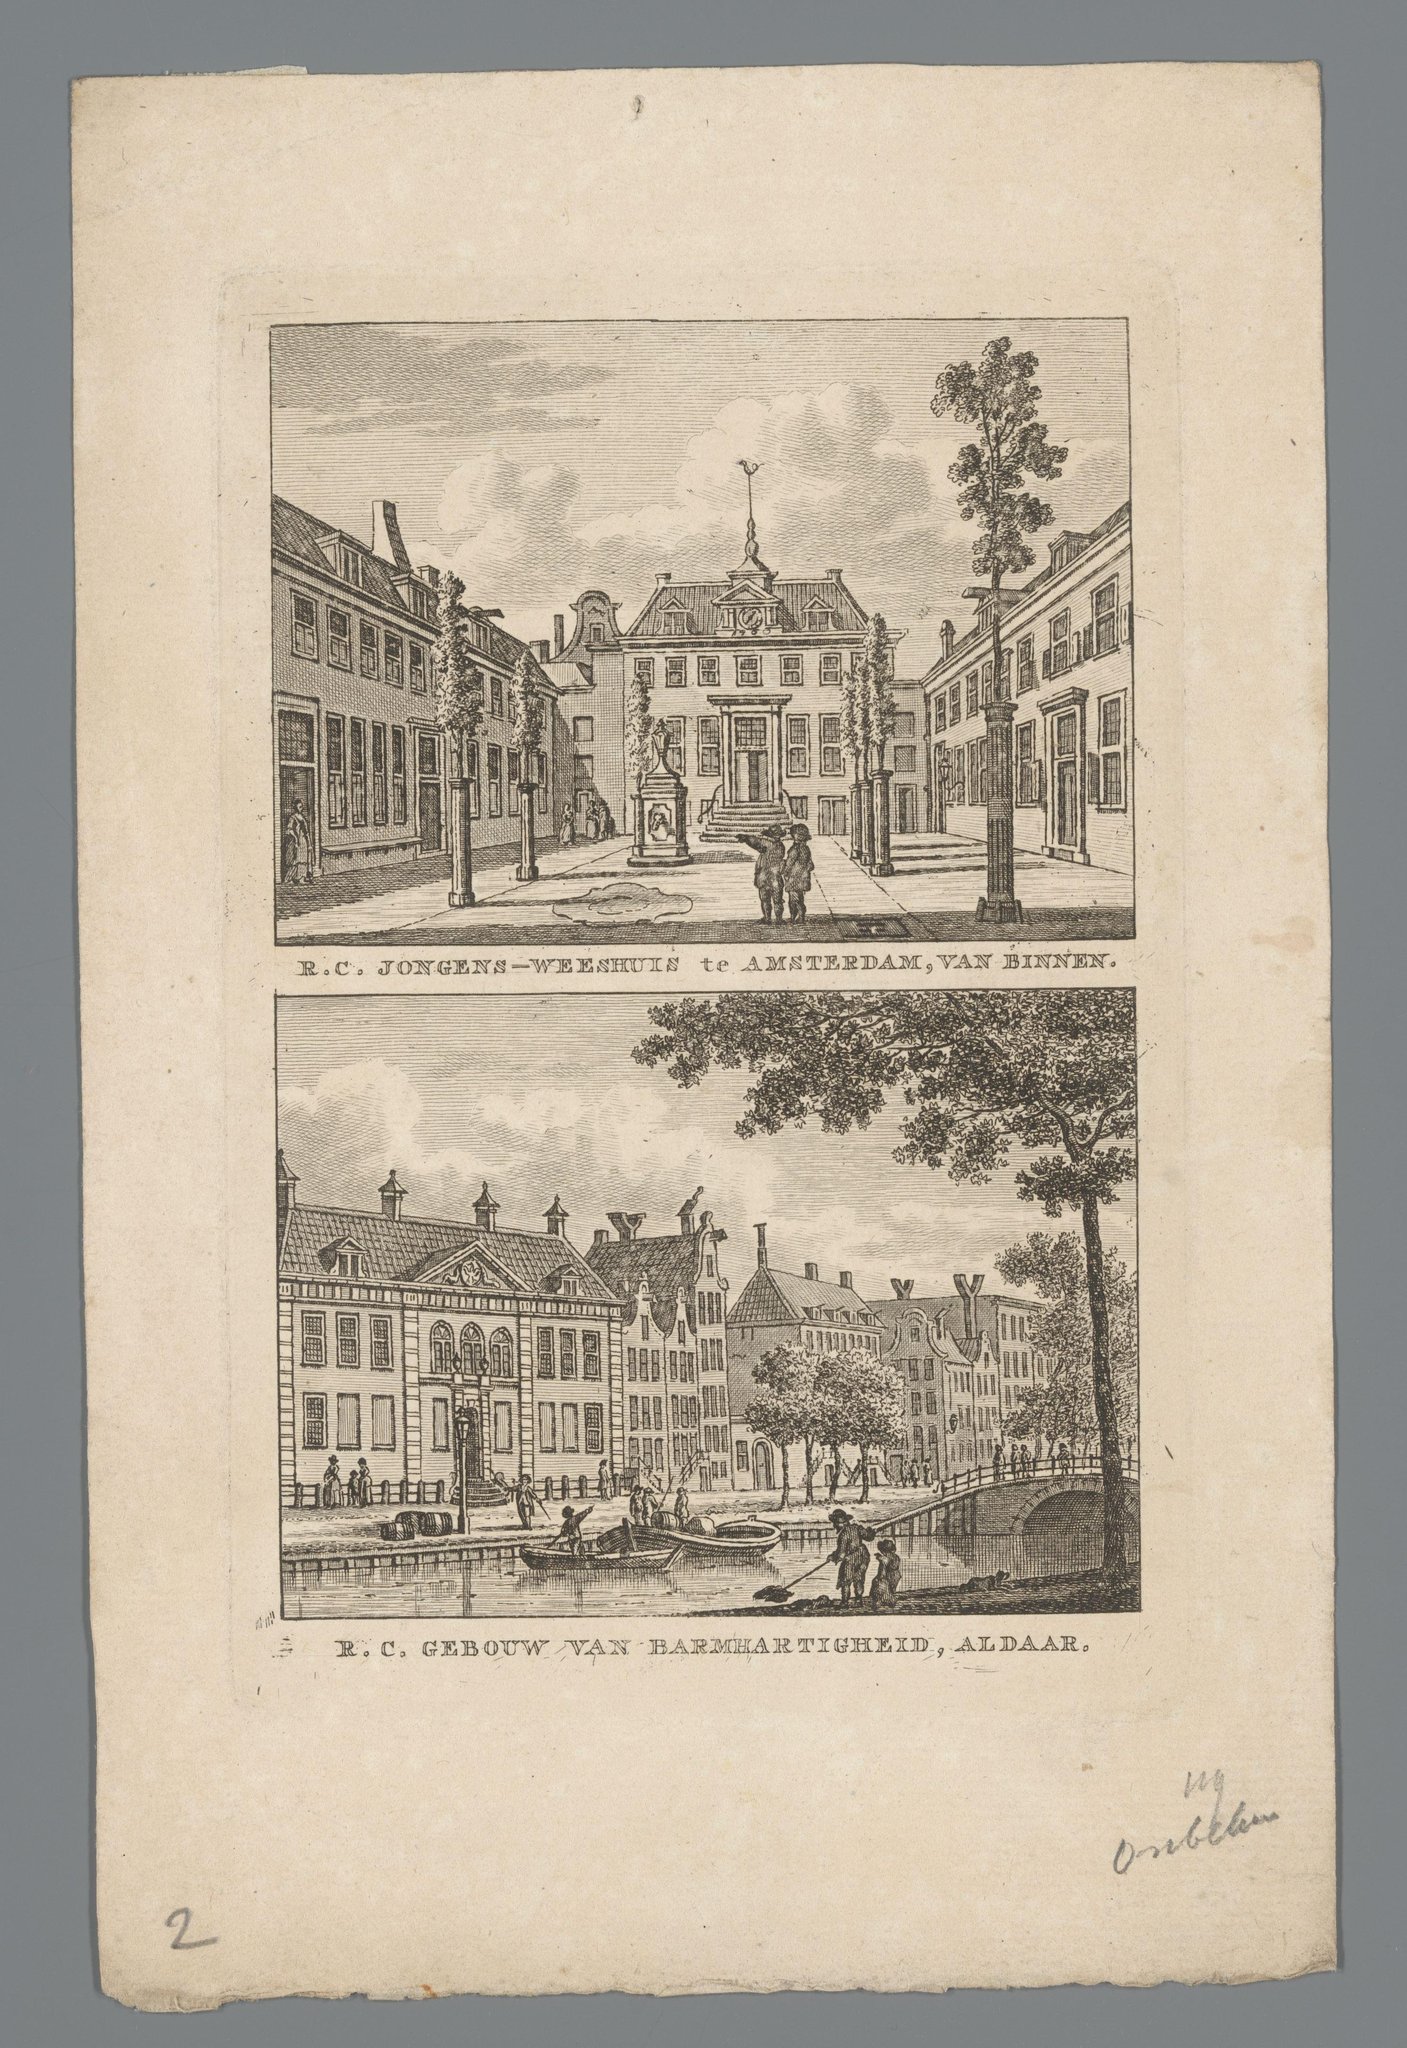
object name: print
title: Gezicht op de Platanenhof en het Gebouw van Barmhartigheid te Amsterdam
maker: carel frederik bendorp (i)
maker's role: print maker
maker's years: 1736-1814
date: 1786-1792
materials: paper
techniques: etching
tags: orphanage, canals, waters (in city) (+ city(-scape) with figures, staffage)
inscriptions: collector's mark: Lugt 2233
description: Prent uit: Vaderlandsche gezichten, of afbeeldingen van den tegenwoordigen staat der Vereenigde Nederlanden (…). Amsterdam: Hendrik Gartman, Willem Vermandel en Jan Willem Smit, 1786-1792. Uitgegeven in afleveringen met ieder een eigen bifolium en inhoudsopgave. Alle prenten in deze publicatie zijn gegraveerd door Carel Frederik Bendorp (I) en, in de meeste gevallen, gebaseerd op tekeningen van Jan Bulthuis.